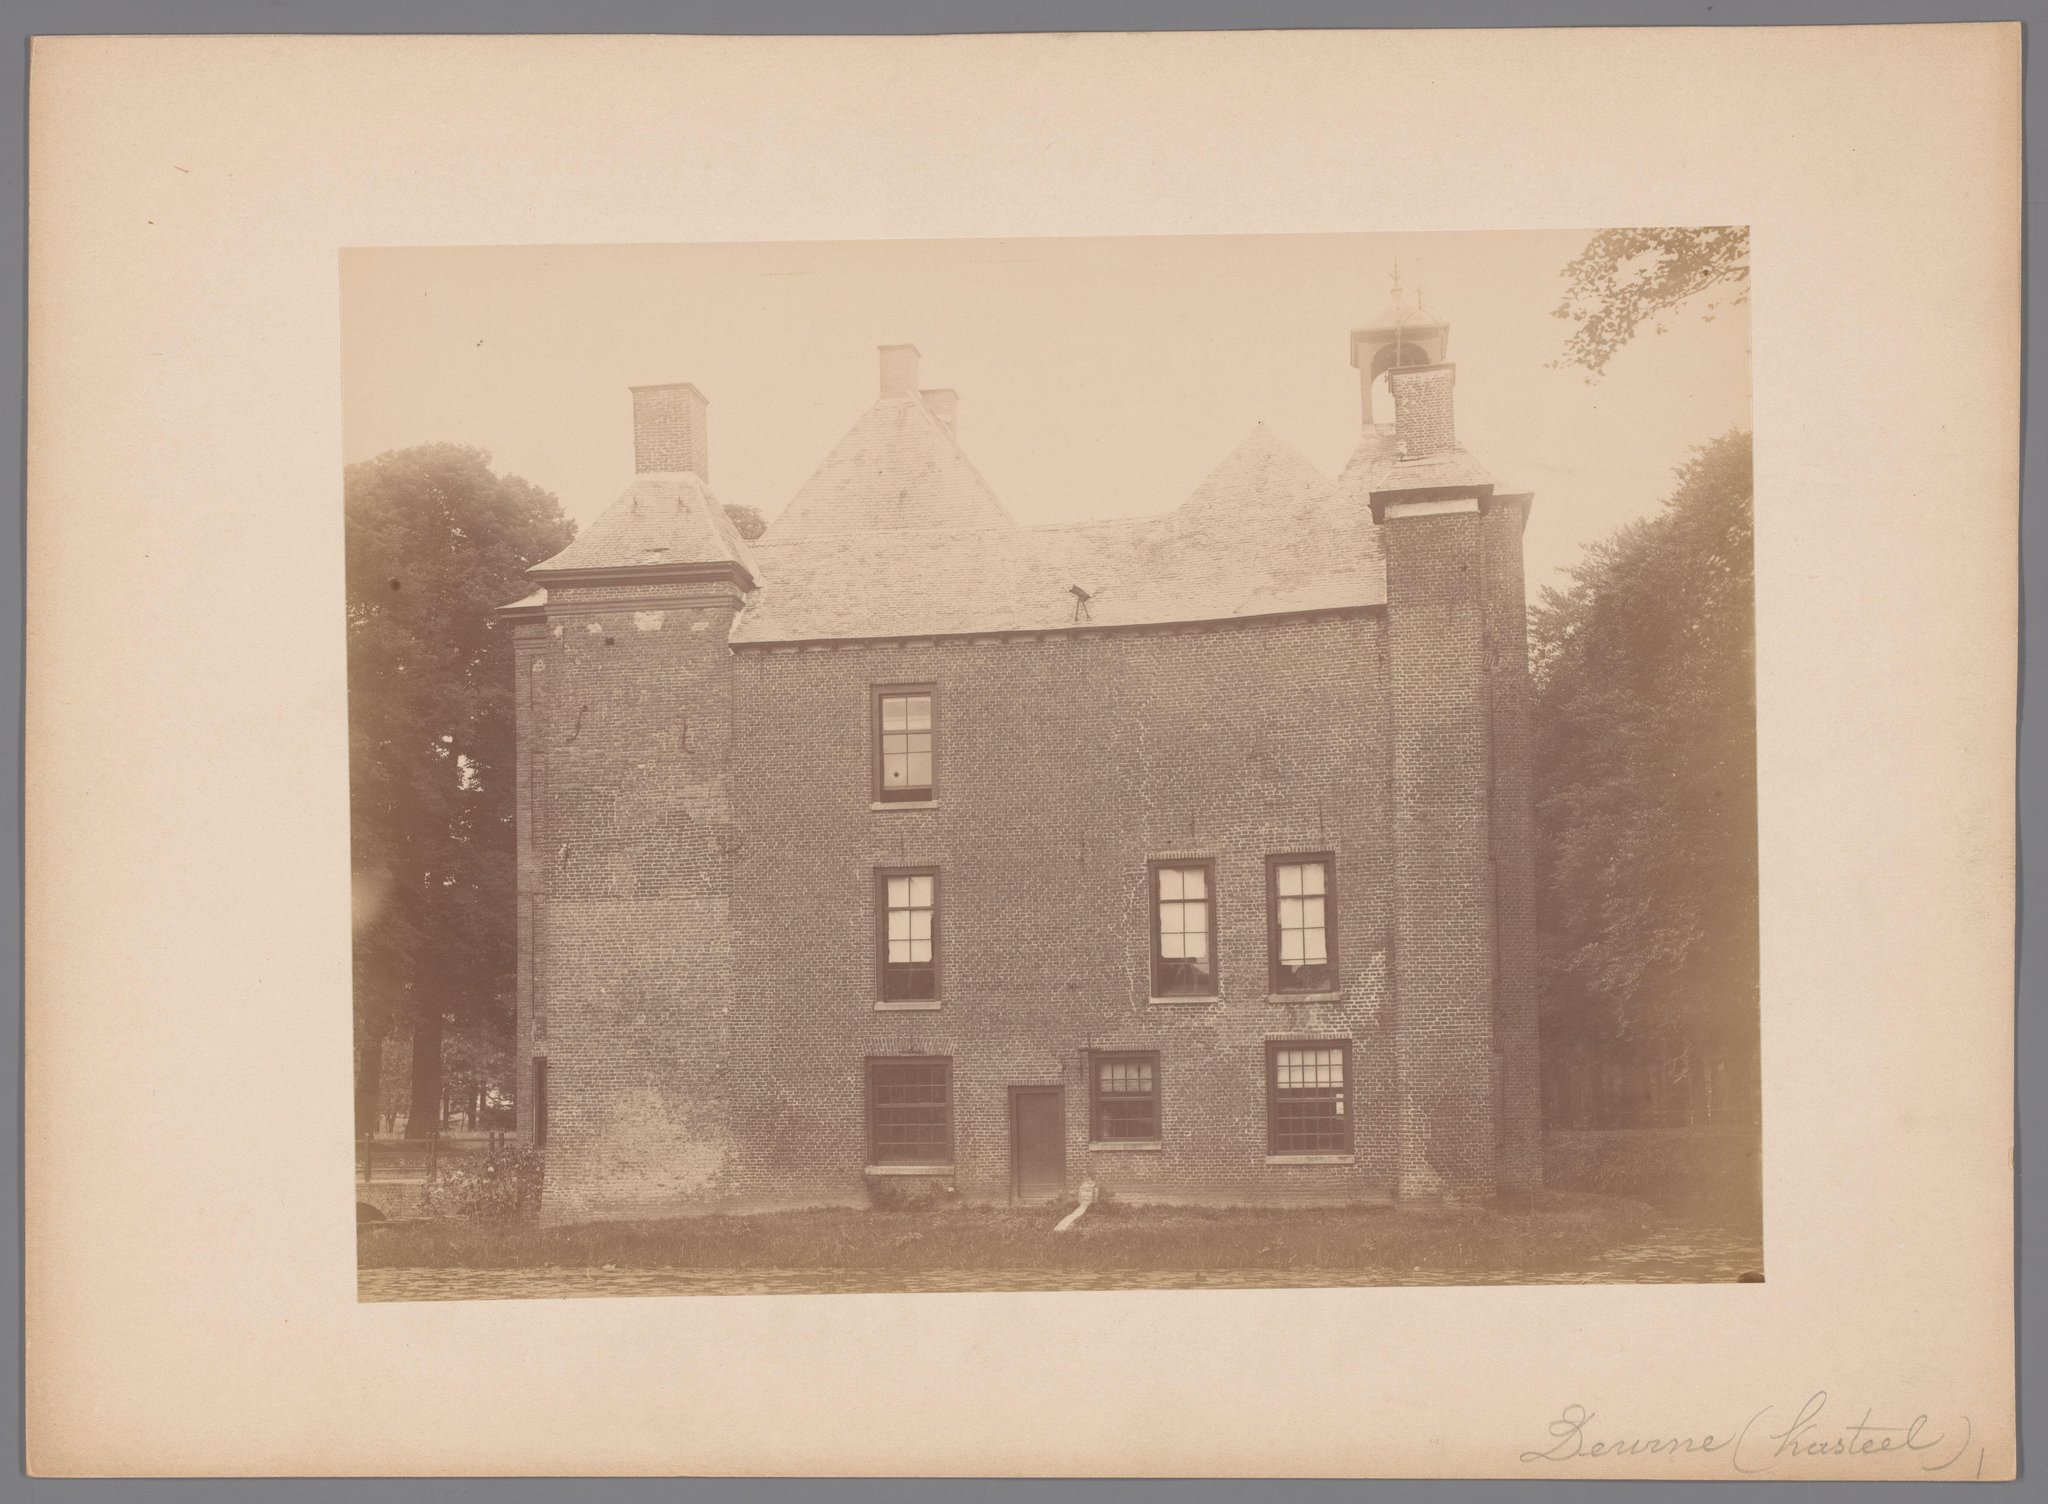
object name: photograph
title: Zuidzijde van het Groot Kasteel bij Deurne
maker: anoniem (monumentenzorg)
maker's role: fotograaf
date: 1890-1920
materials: cardboard, photographic support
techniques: albumen print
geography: deurne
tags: castle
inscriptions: annotation: ‘Kasteel te Deurne/ Zuidfront’, annotation: ‘Deurne (kasteel)’